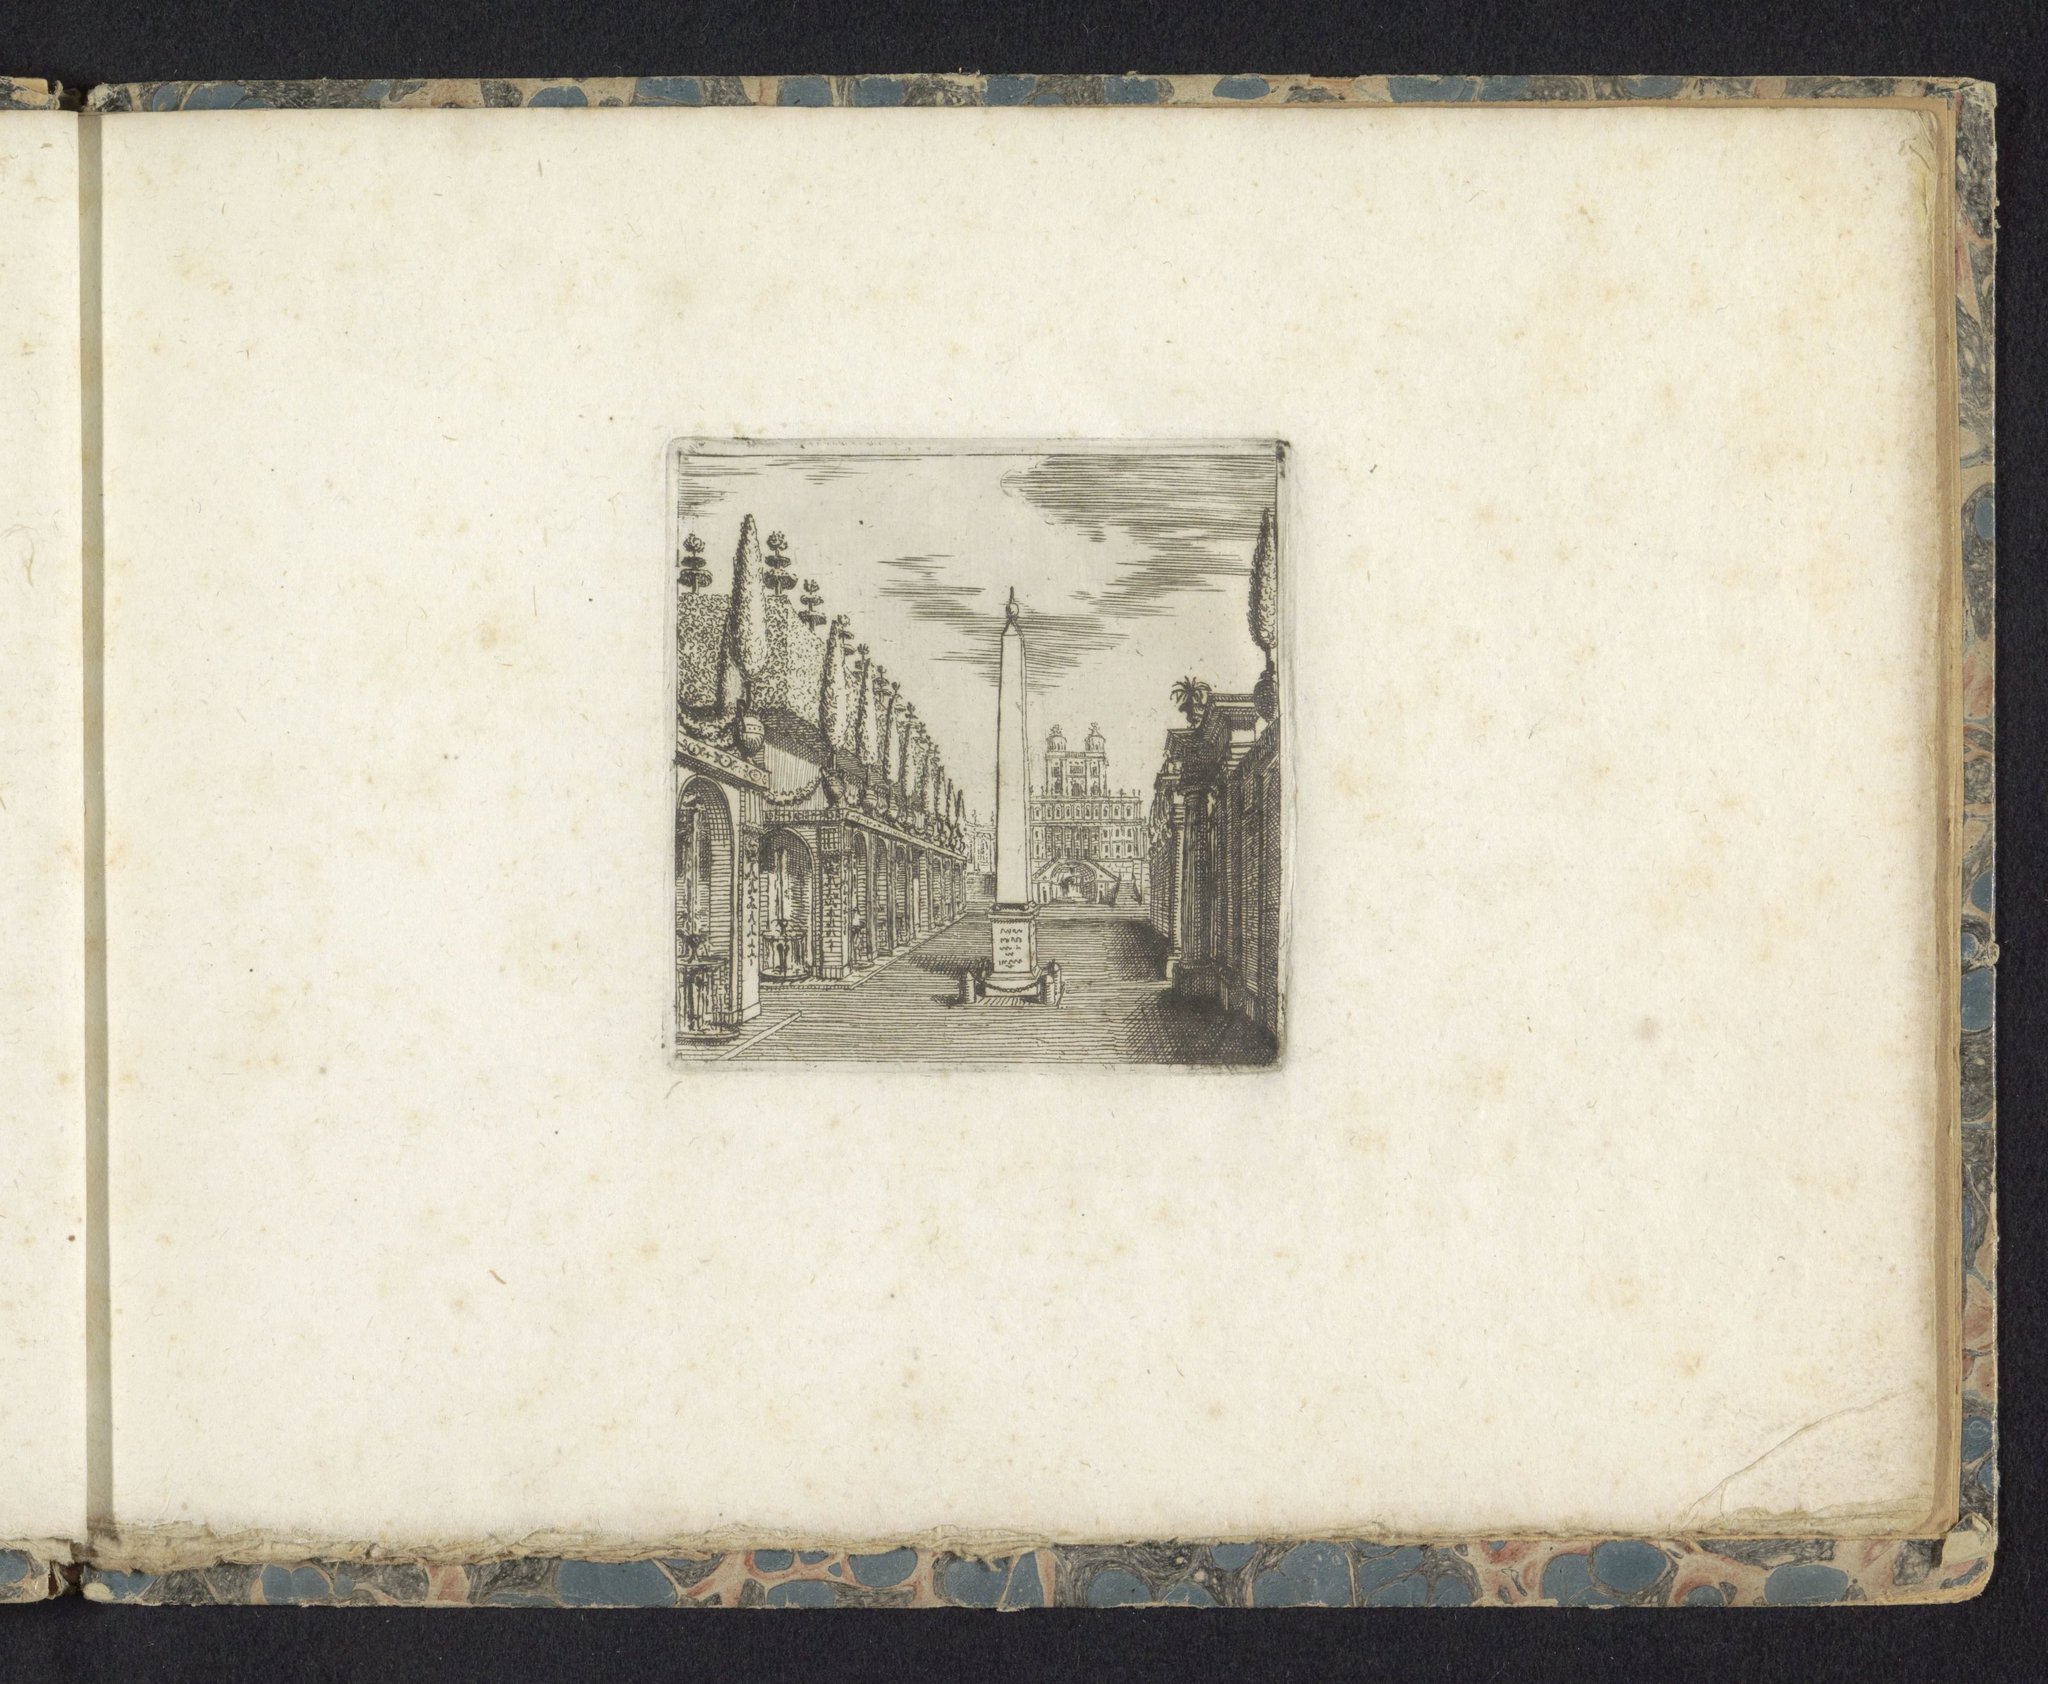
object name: album leaf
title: Decorontwerp met een paleistuin met obelisk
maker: Anonymous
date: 1750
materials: paper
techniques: etching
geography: italy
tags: set, scenery ~ stage, obelisk, needle, garden, palace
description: Deze prent maakt deel uit van een reeks van ten minste dertien prenten met decorontwerpen.